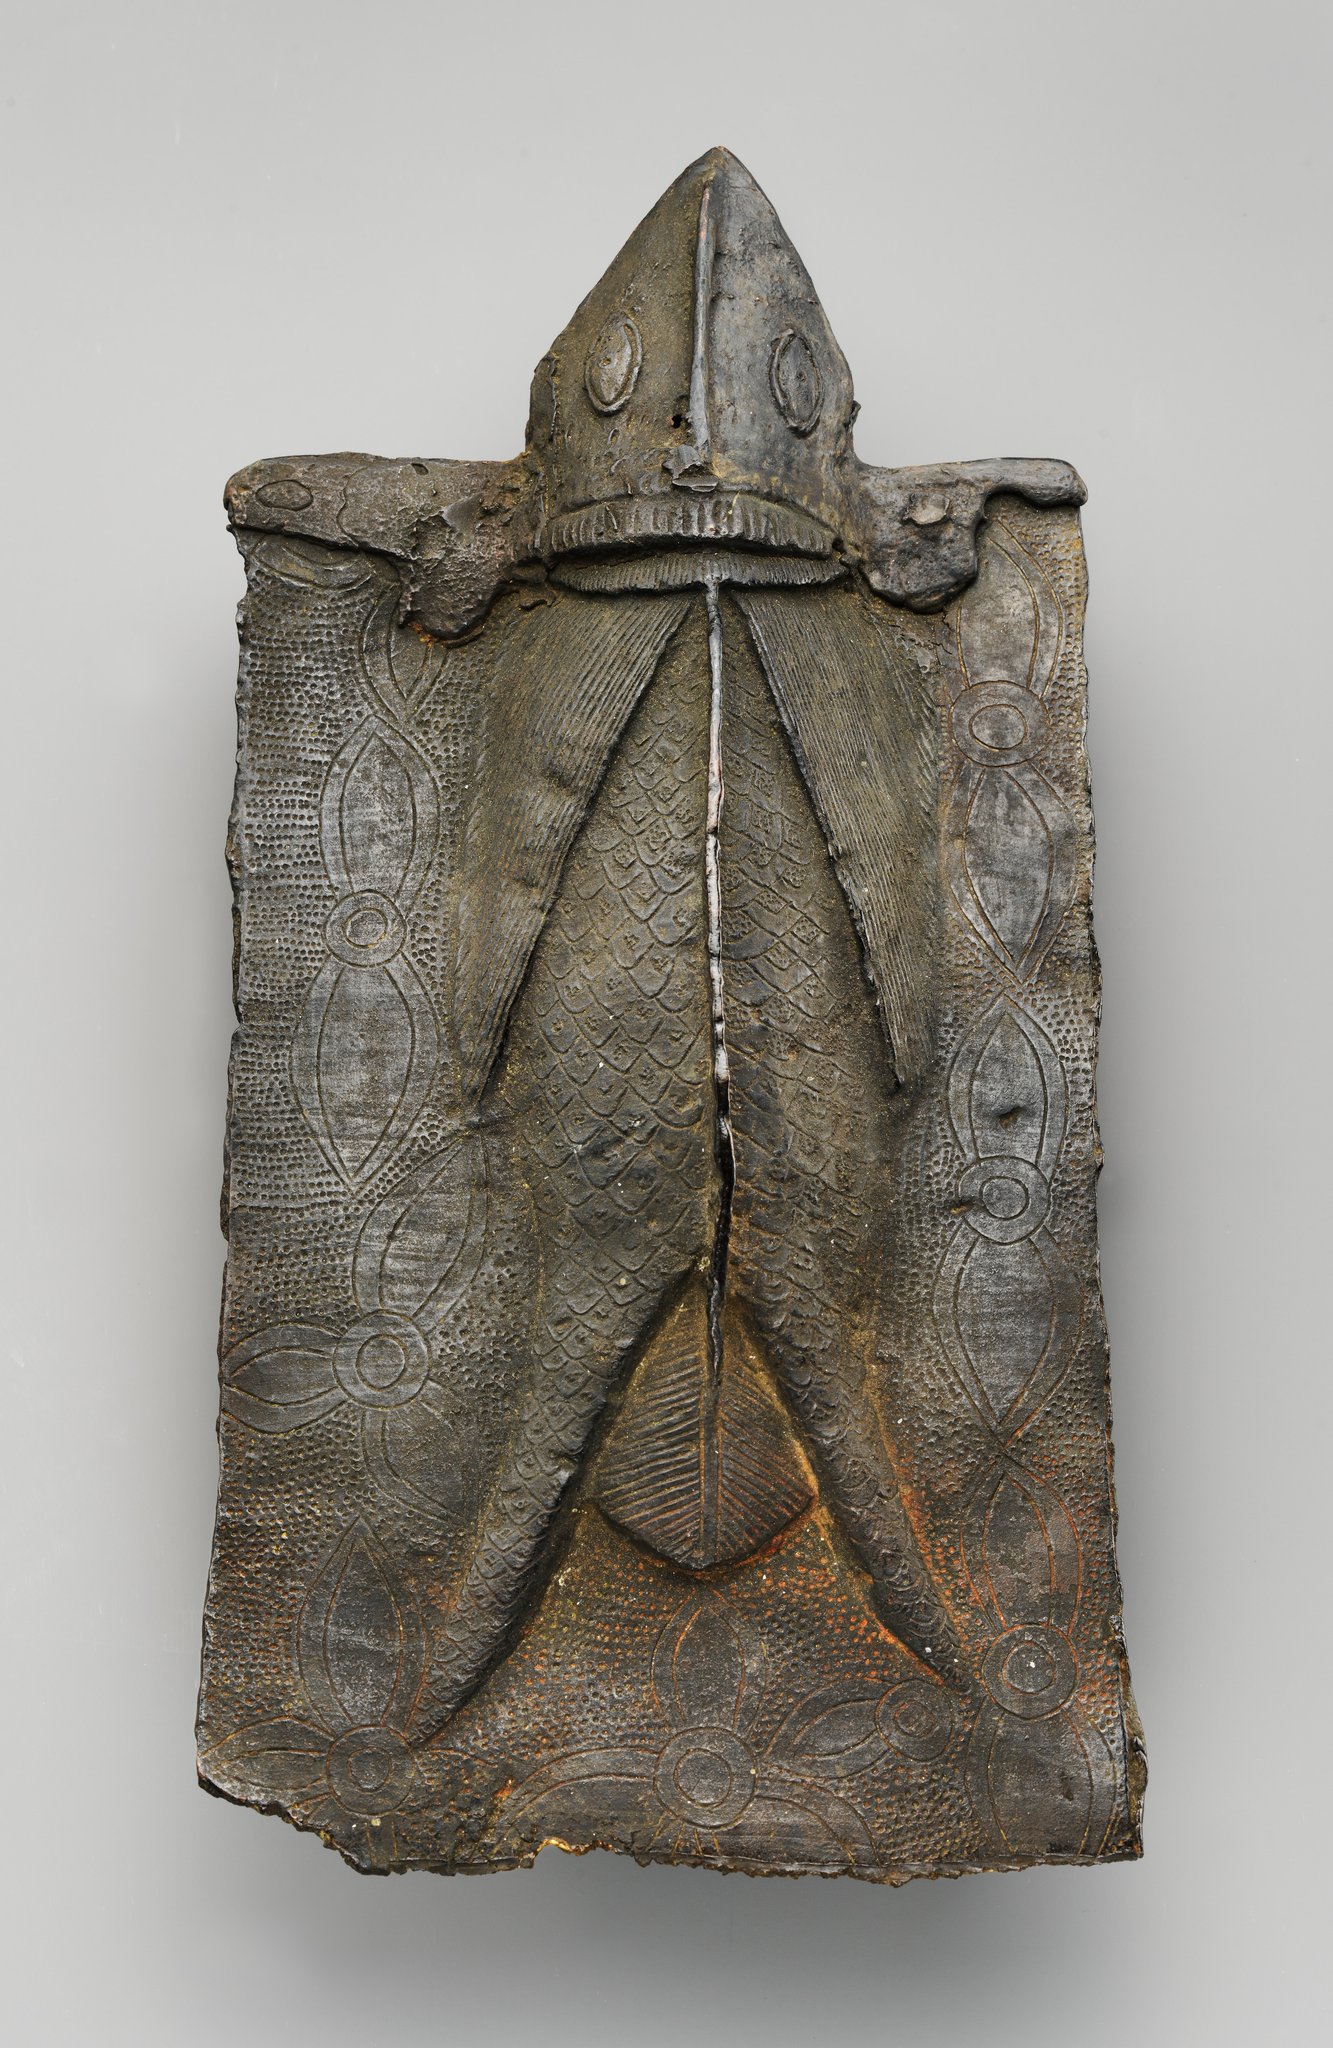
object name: plaque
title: Plaque: Mudfish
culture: edo period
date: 1501-1700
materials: brass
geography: nigeria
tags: fish